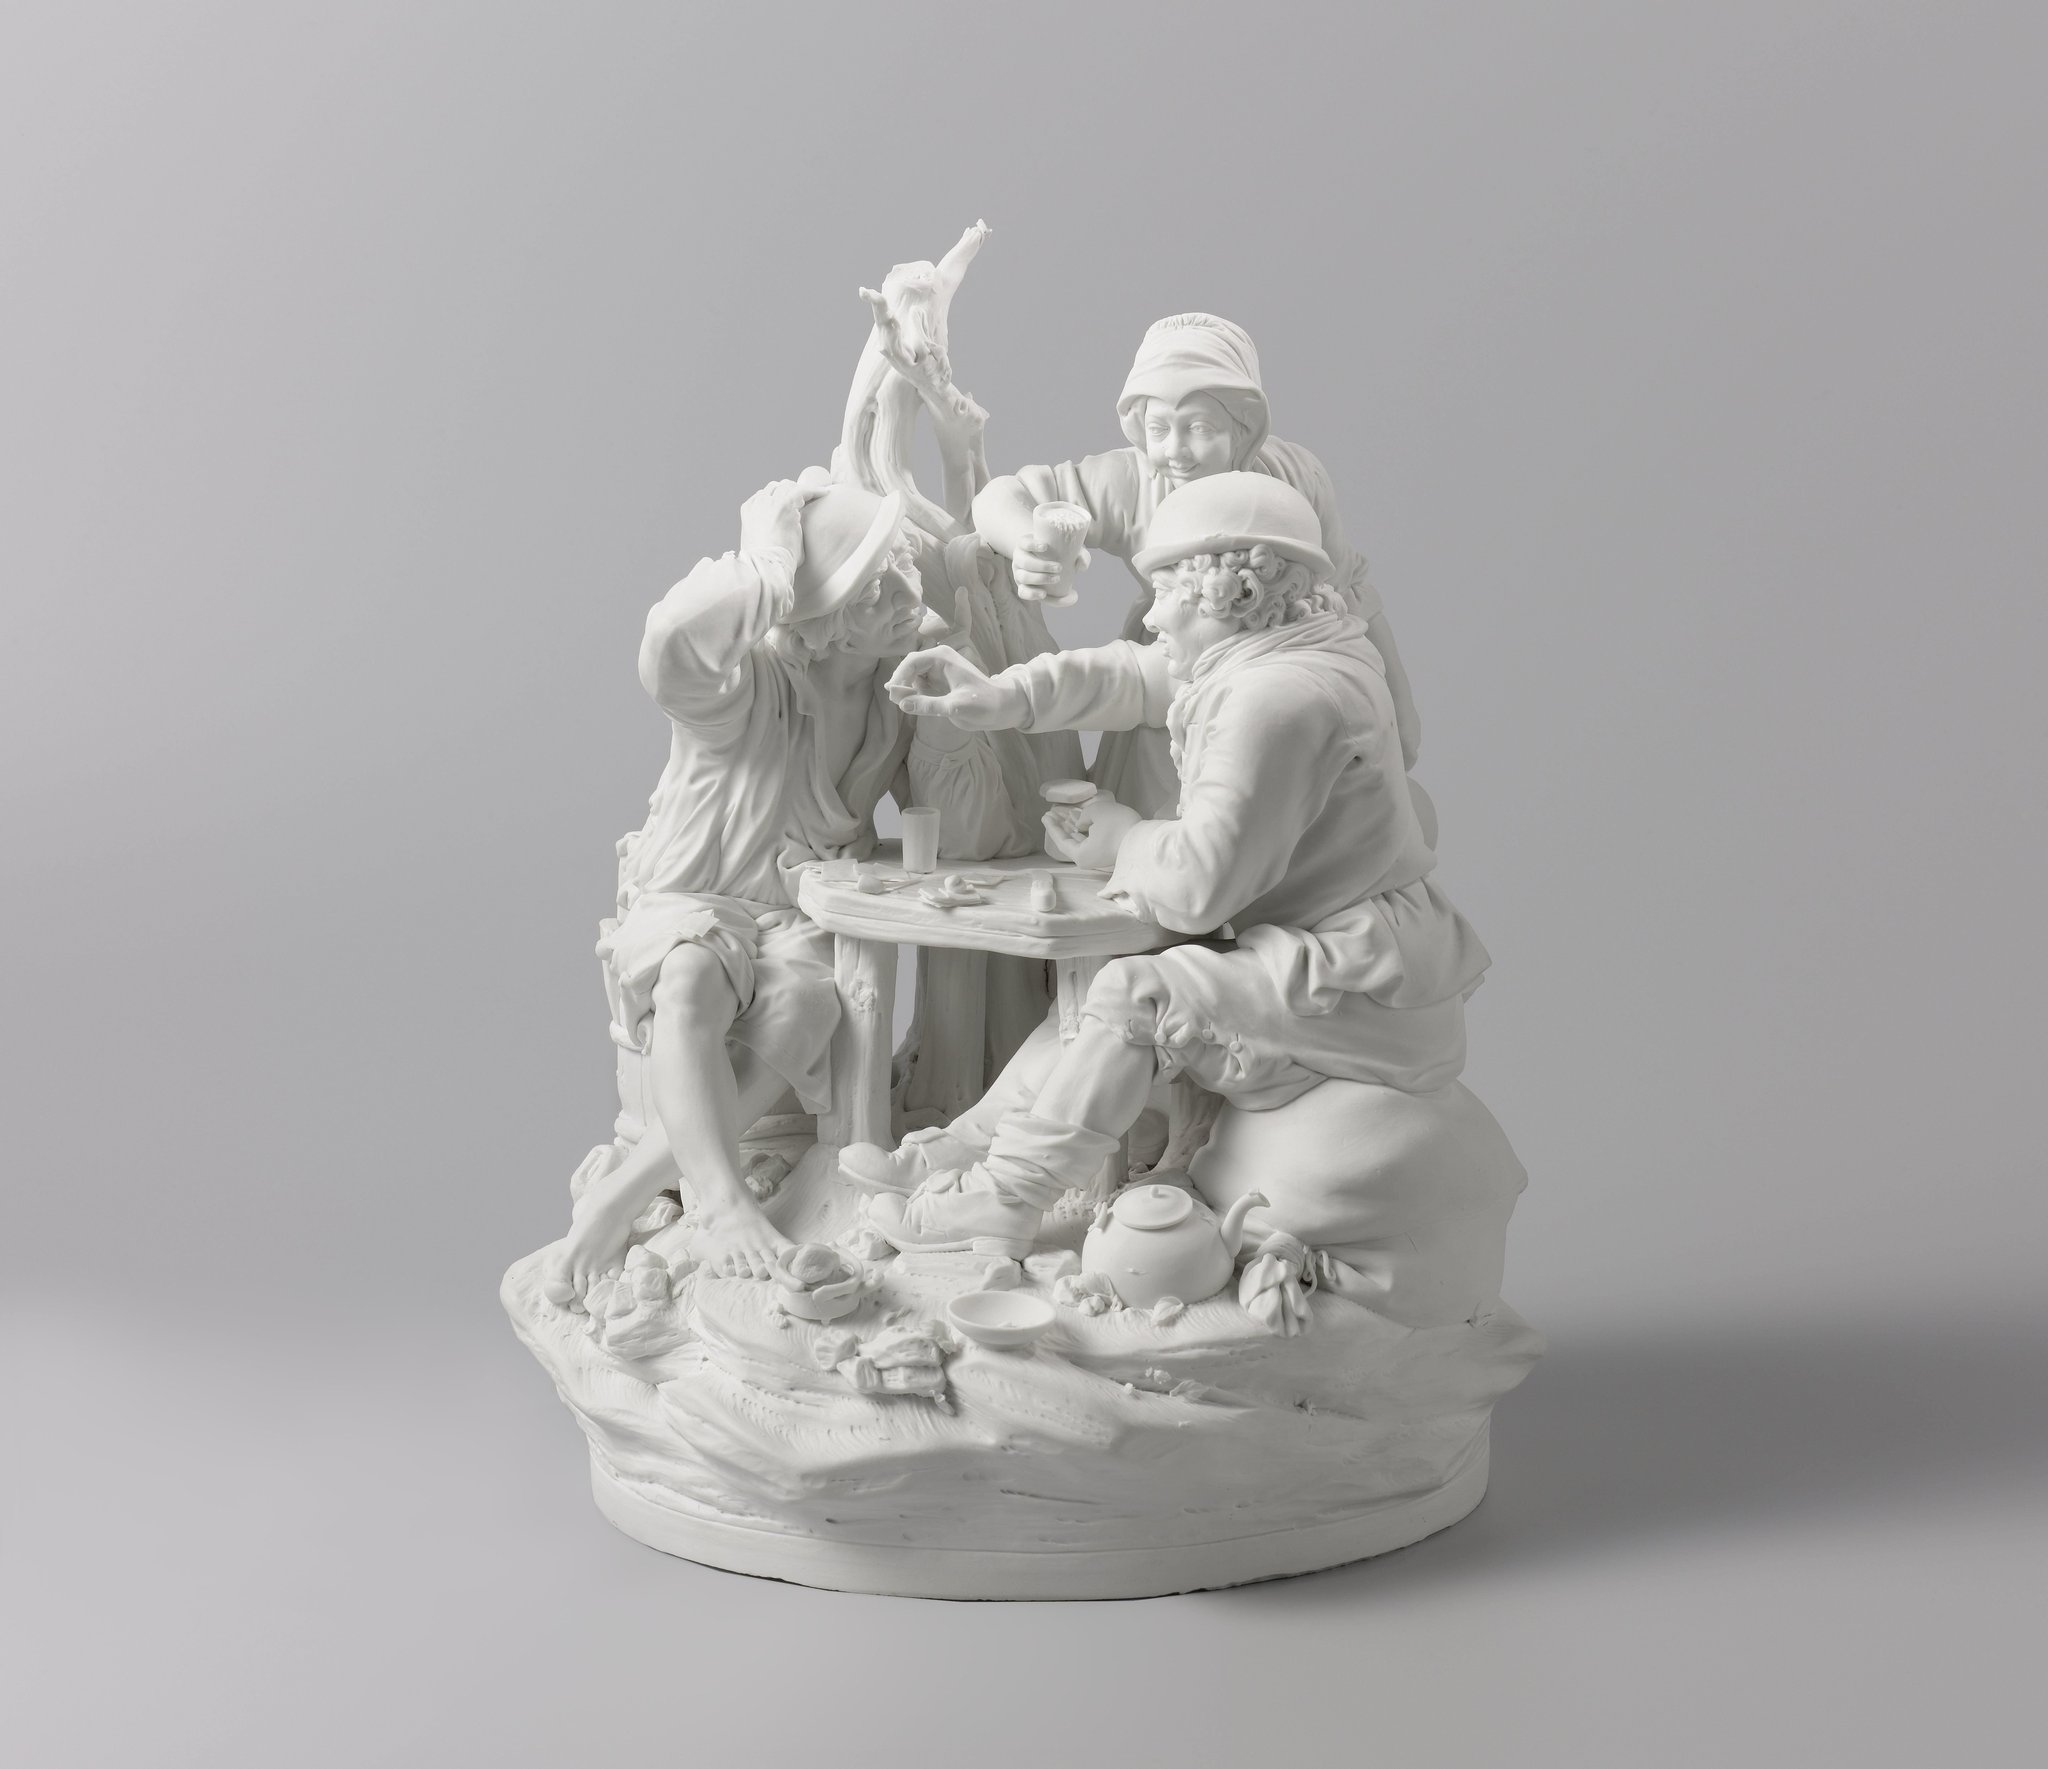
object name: figure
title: Figures Playing Cards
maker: Anonymous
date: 1780-1784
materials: biscuit porcelain, material)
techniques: biscuit (porcelain, material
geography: loosdrecht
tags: playing-cards, waiting at table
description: This finely modelled, well-observed porcelain group depicts a boorish scene in which the figures are lustfully eating, drinking and playing cards.